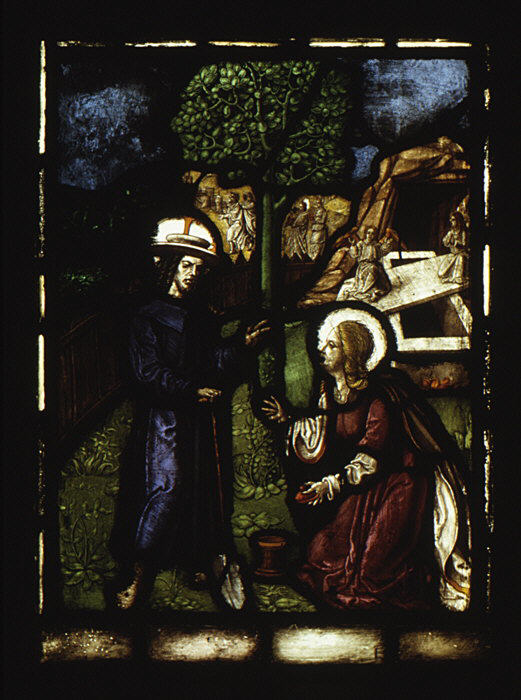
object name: panel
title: Christ Appearing to Saint Mary Magdalene (one of a set of 12 scenes from The Life of Christ)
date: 1525-1530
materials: glass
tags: mary magdalene,jesus,saints